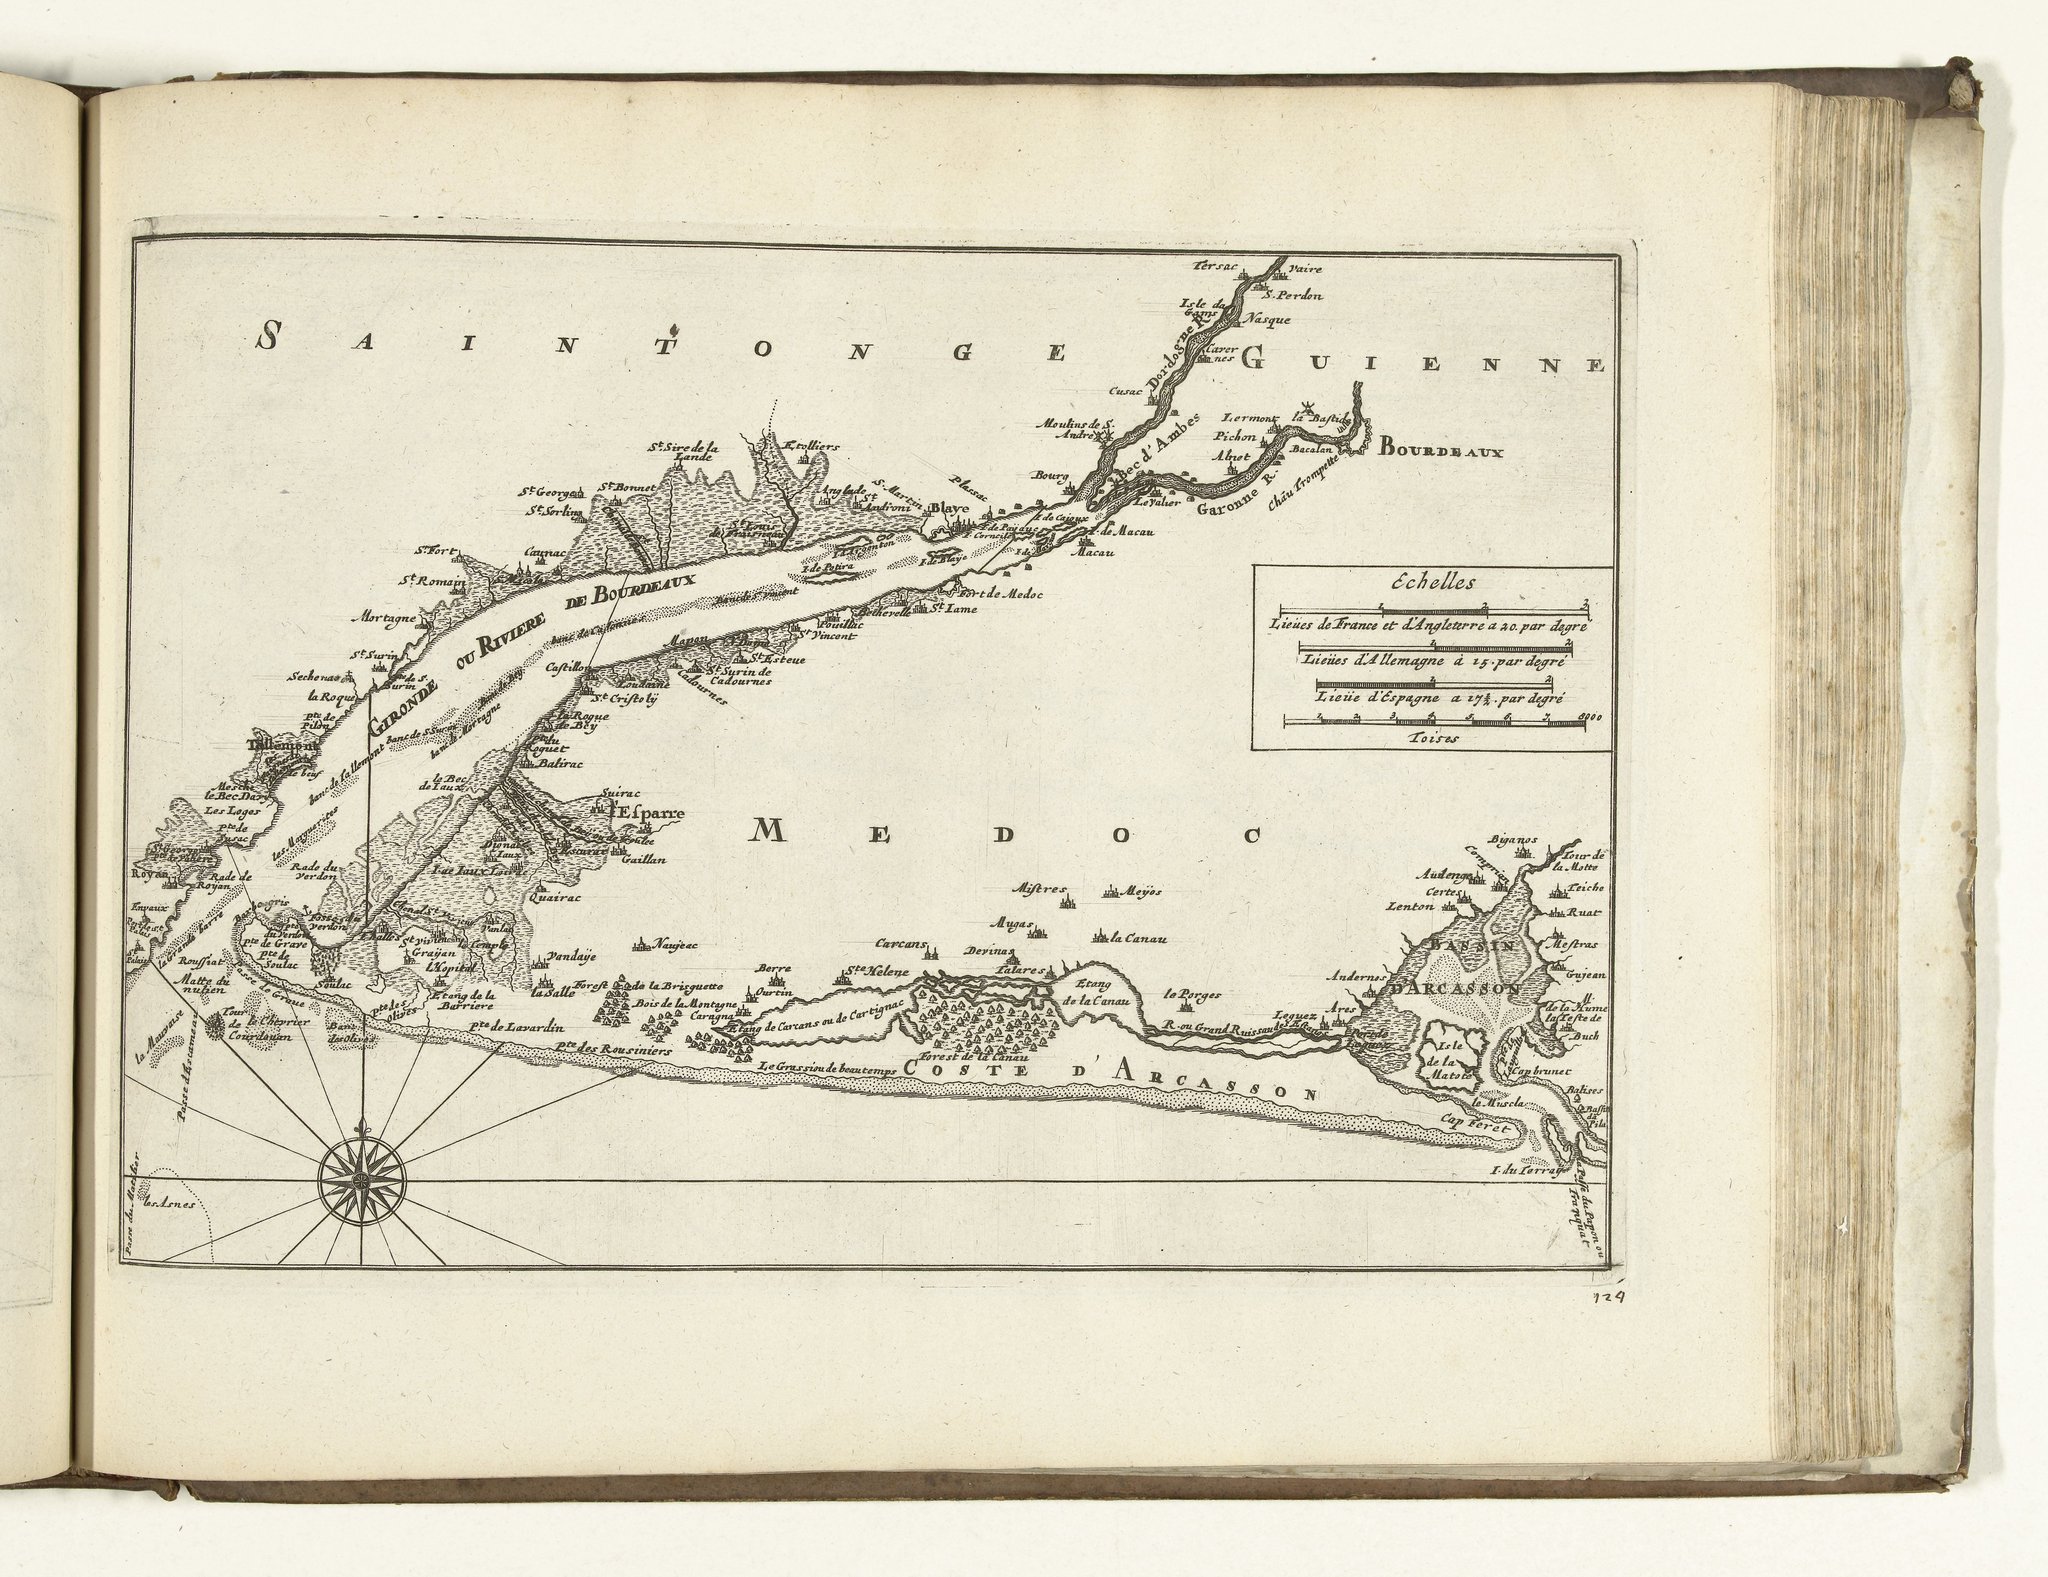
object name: map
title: Kaart van de Franse westkust met de monding van de Garonne en Dordogne, 1726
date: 1726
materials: paper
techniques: etching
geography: northern netherlands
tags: maps of separate countries or regions, france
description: Kaart van de Franse westkust met de monding van de Garonne en Dordogne. Plaat nr. 124 in deel VI van het prentwerk: Les Forces de l'Europe, Asie, Afrique et Amerique ... Comme aussi les Cartes des Côtes de France et d'Espagne uit 1726, dit eerste deel met 238 met de hand genummerde platen van vermaarde sterke steden en vestingen in het kader van de Spaanse Successieoorlog 1701-1713. Voor het merendeel zijn deze platen gekopieerd naar de anonieme Franse platen van vermaarde sterke steden en vestingen: in Les forces de l'Europe en in: Le theatre de la guerre, dans les Pays-Bas, beide oorspronkelijk uitgegeven door Nicolas de Fer te Parijs (1693-1697) in het kader van de Negenjarige Oorlog. Opschriften in het Frans.